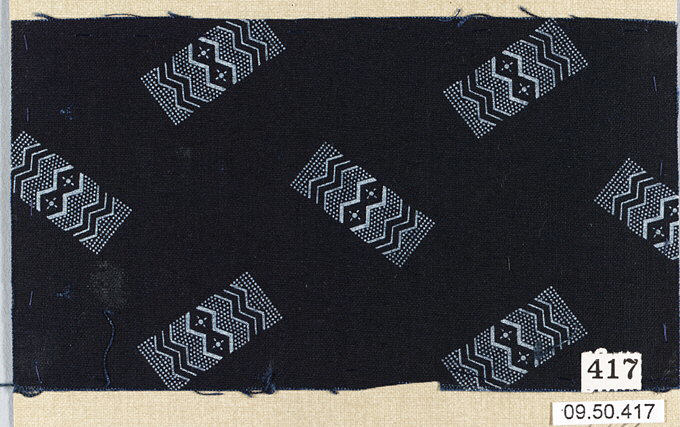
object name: piece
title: Piece (one of 116)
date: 1801-1900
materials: cotton